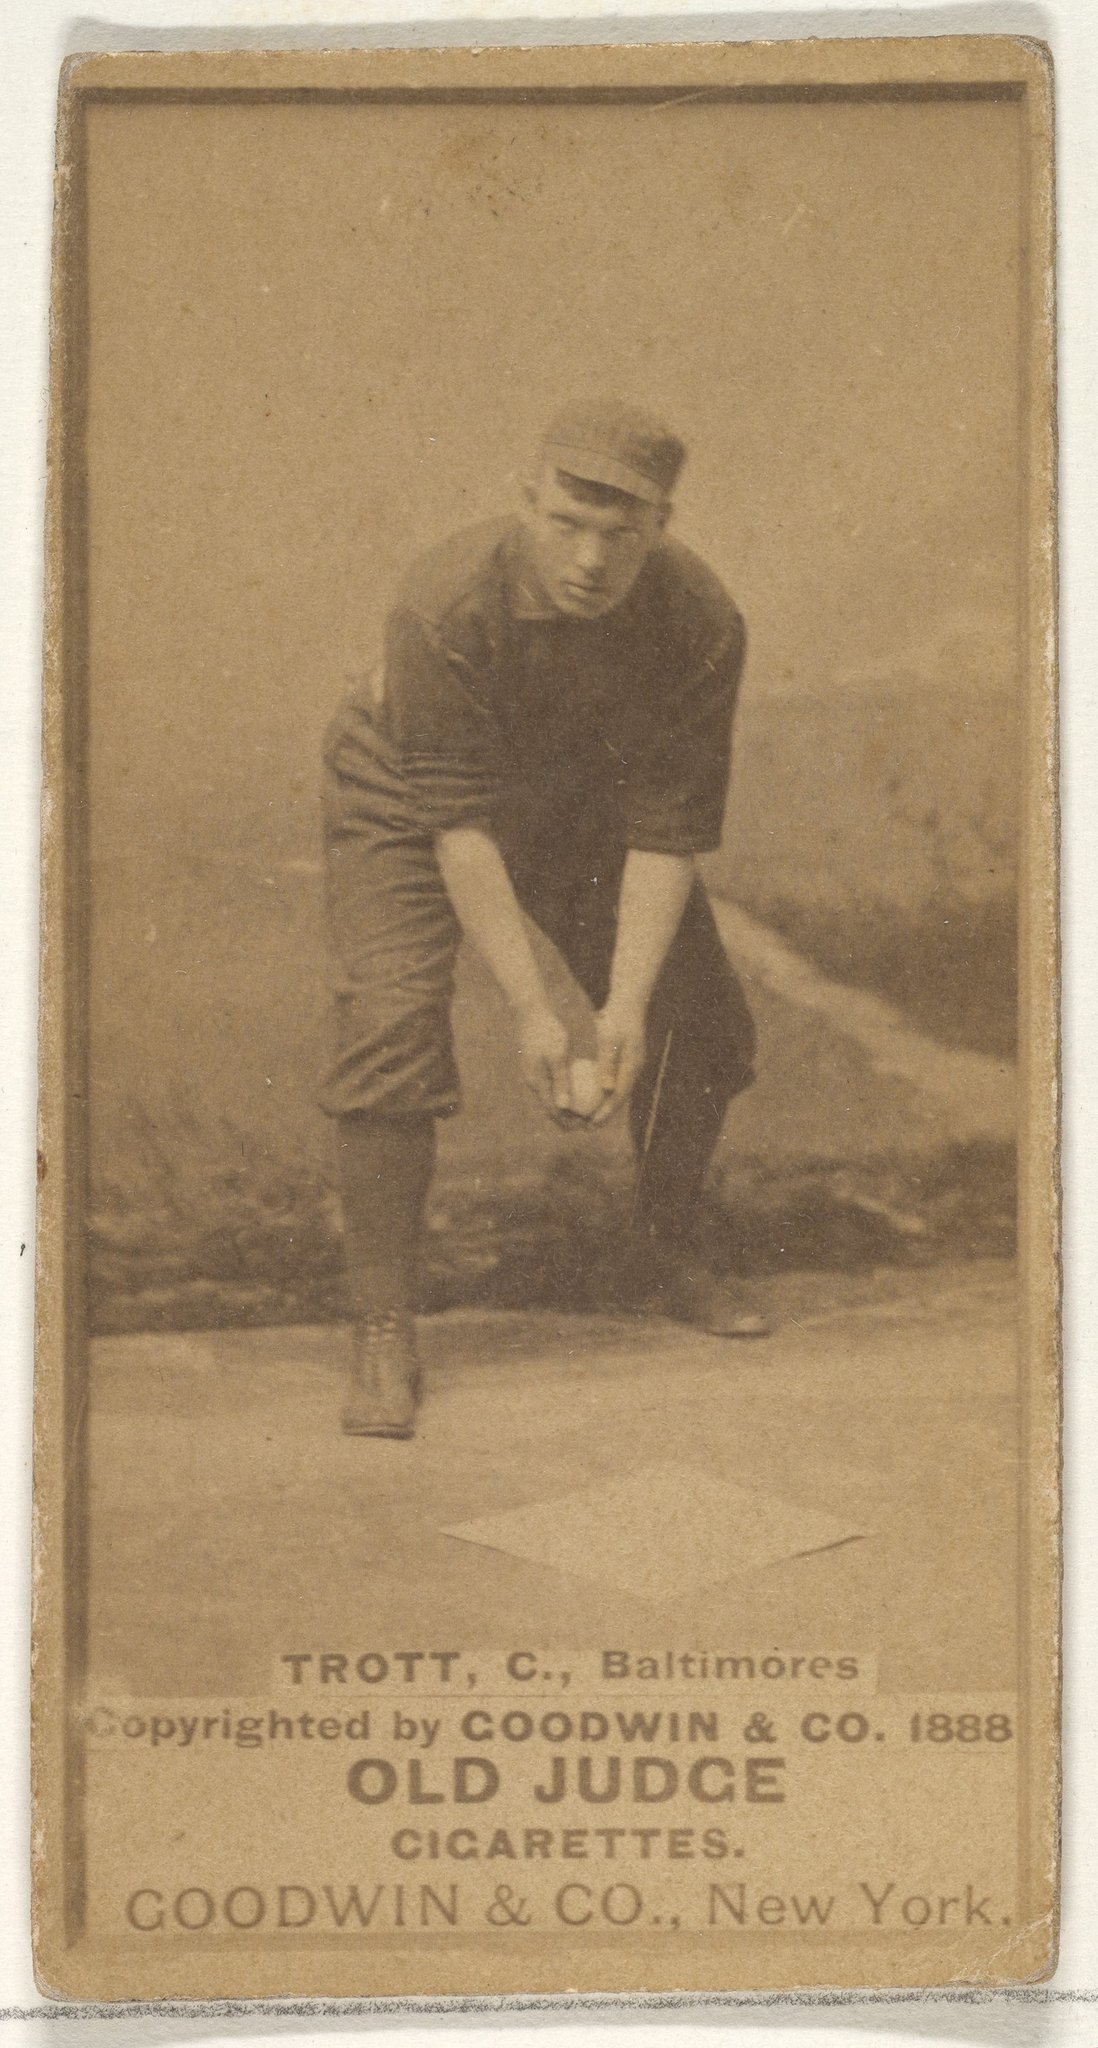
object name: baseball card, photograph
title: Trott, Catcher, Baltimore Orioles, from the Old Judge series (N172) for Old Judge Cigarettes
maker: goodwin & company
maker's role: publisher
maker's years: 1850-1950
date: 1888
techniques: albumen silver print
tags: men,portraits,baseball,athletes